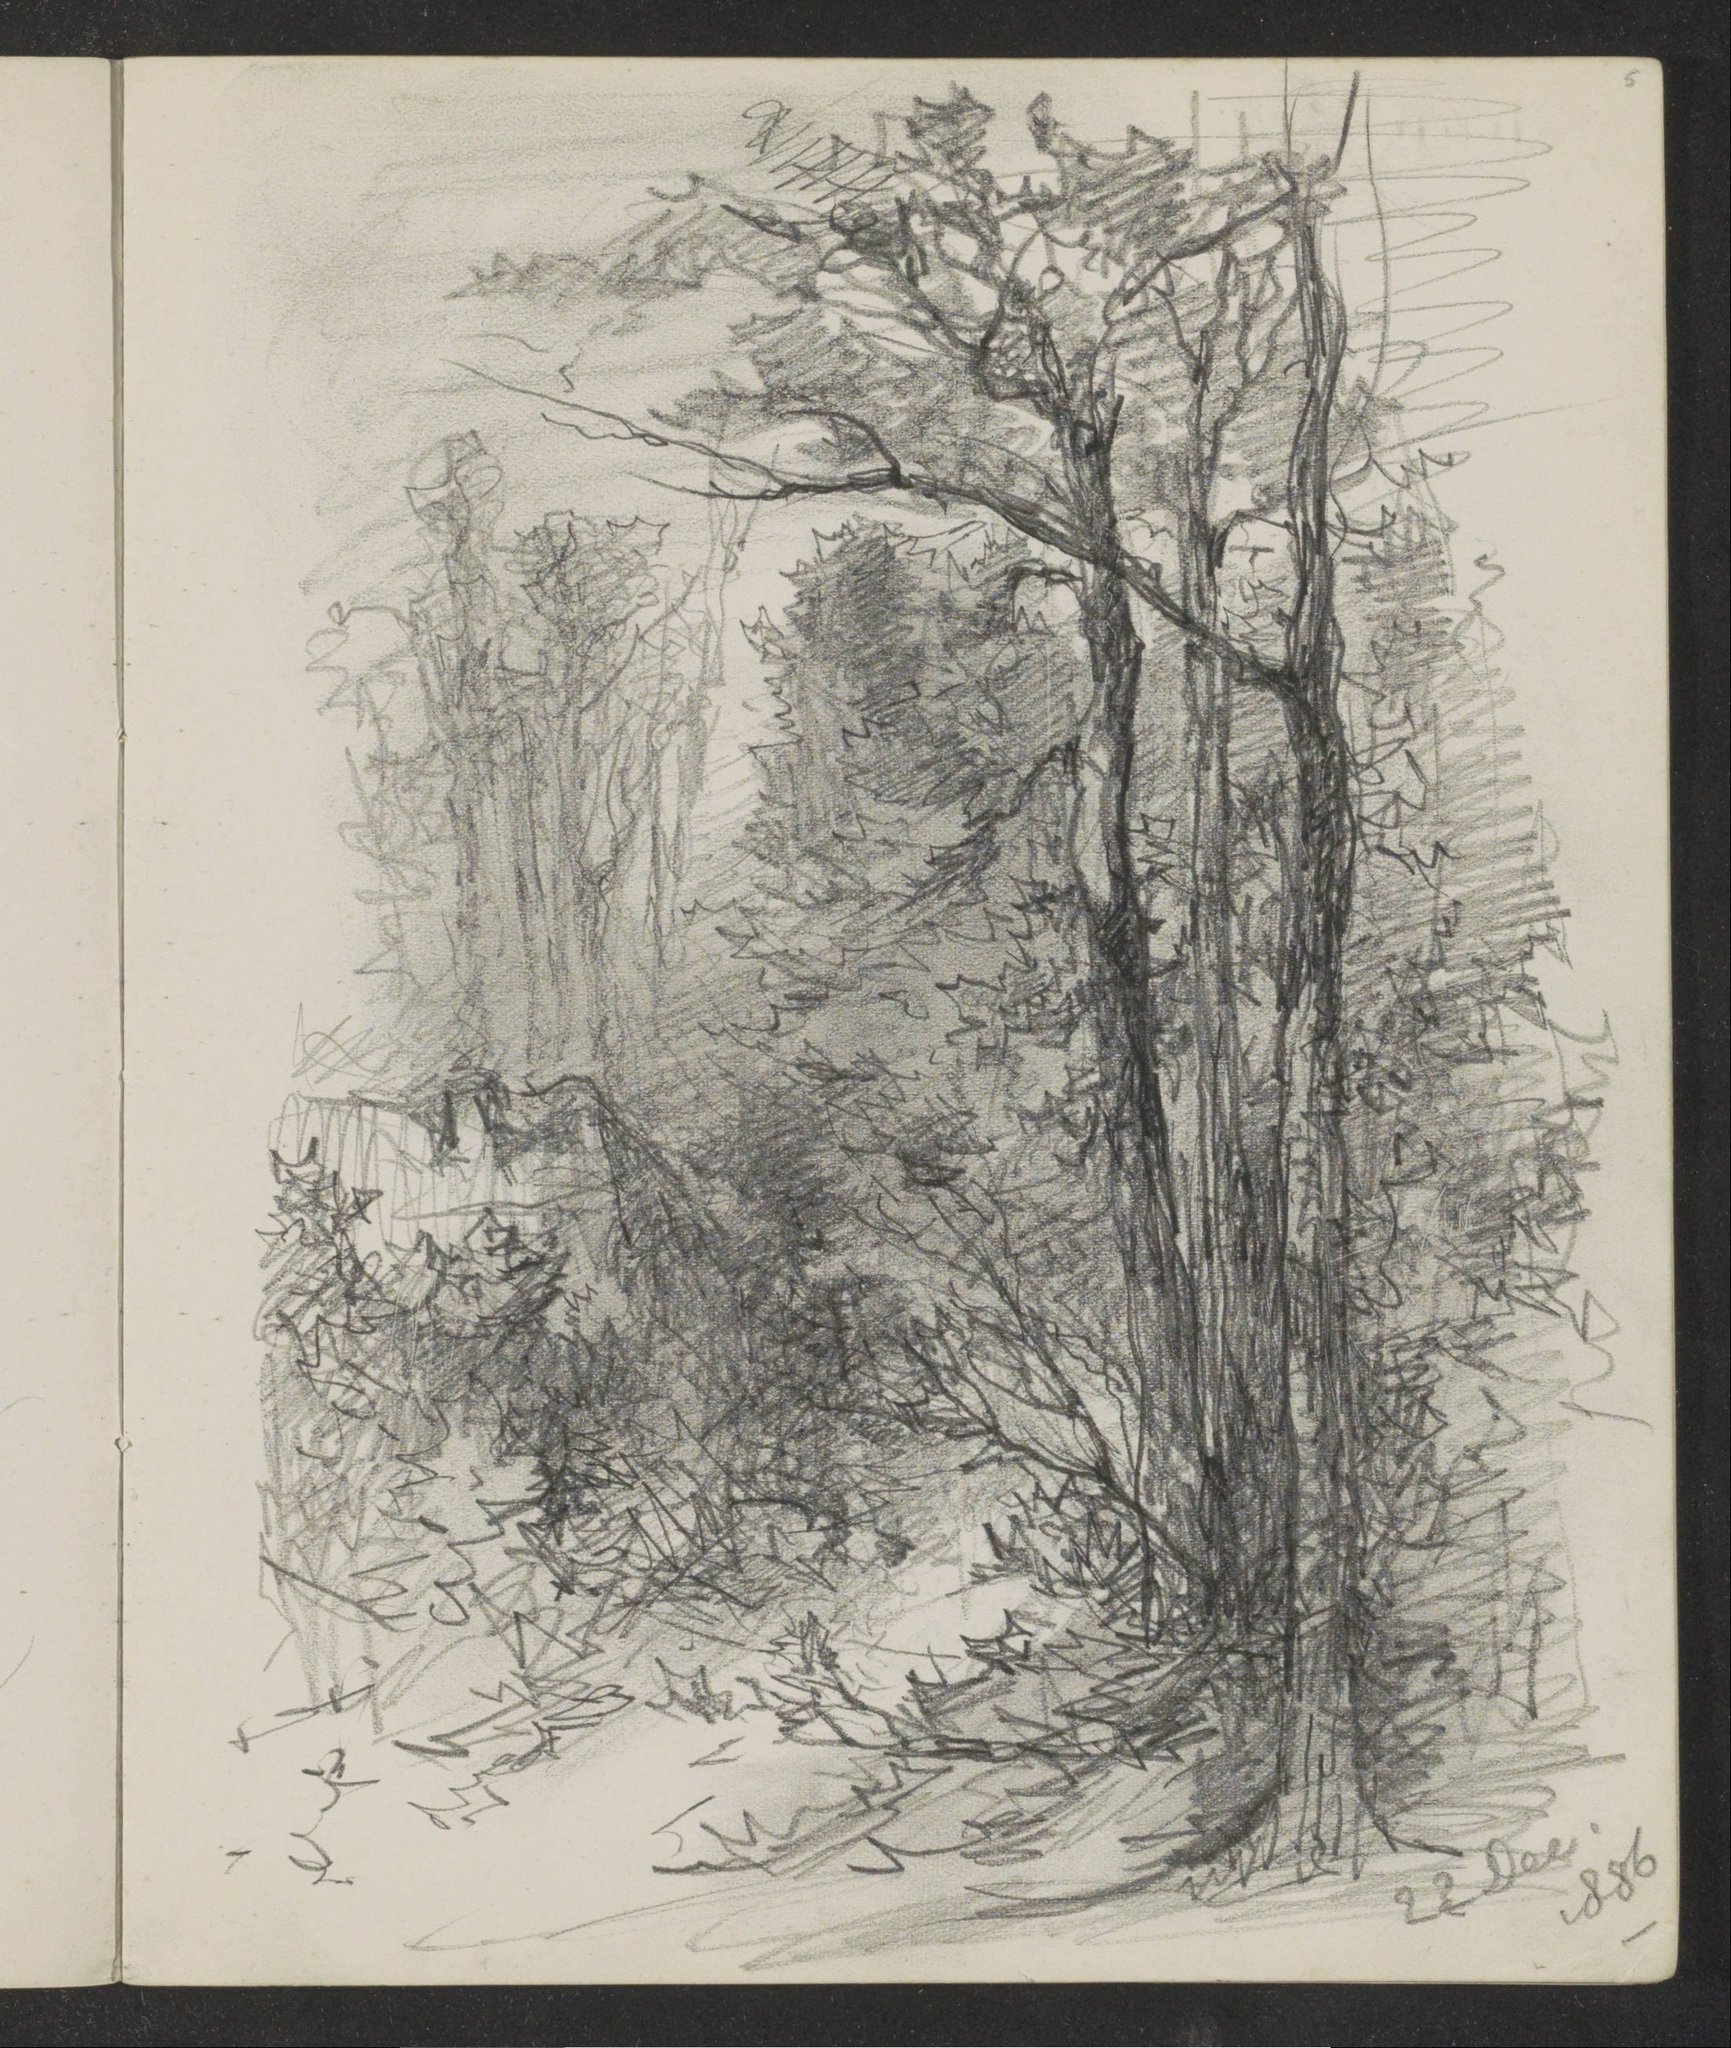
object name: sketchbook leaf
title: Bospad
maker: maria vos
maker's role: draughtsman, painter, print maker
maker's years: 1824-1906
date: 1812-1886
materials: paper, pencil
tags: forest path or lane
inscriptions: date: ‘22 Dec./ 1886’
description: Blad 5 recto uit een schetsboek met 17 bladen.